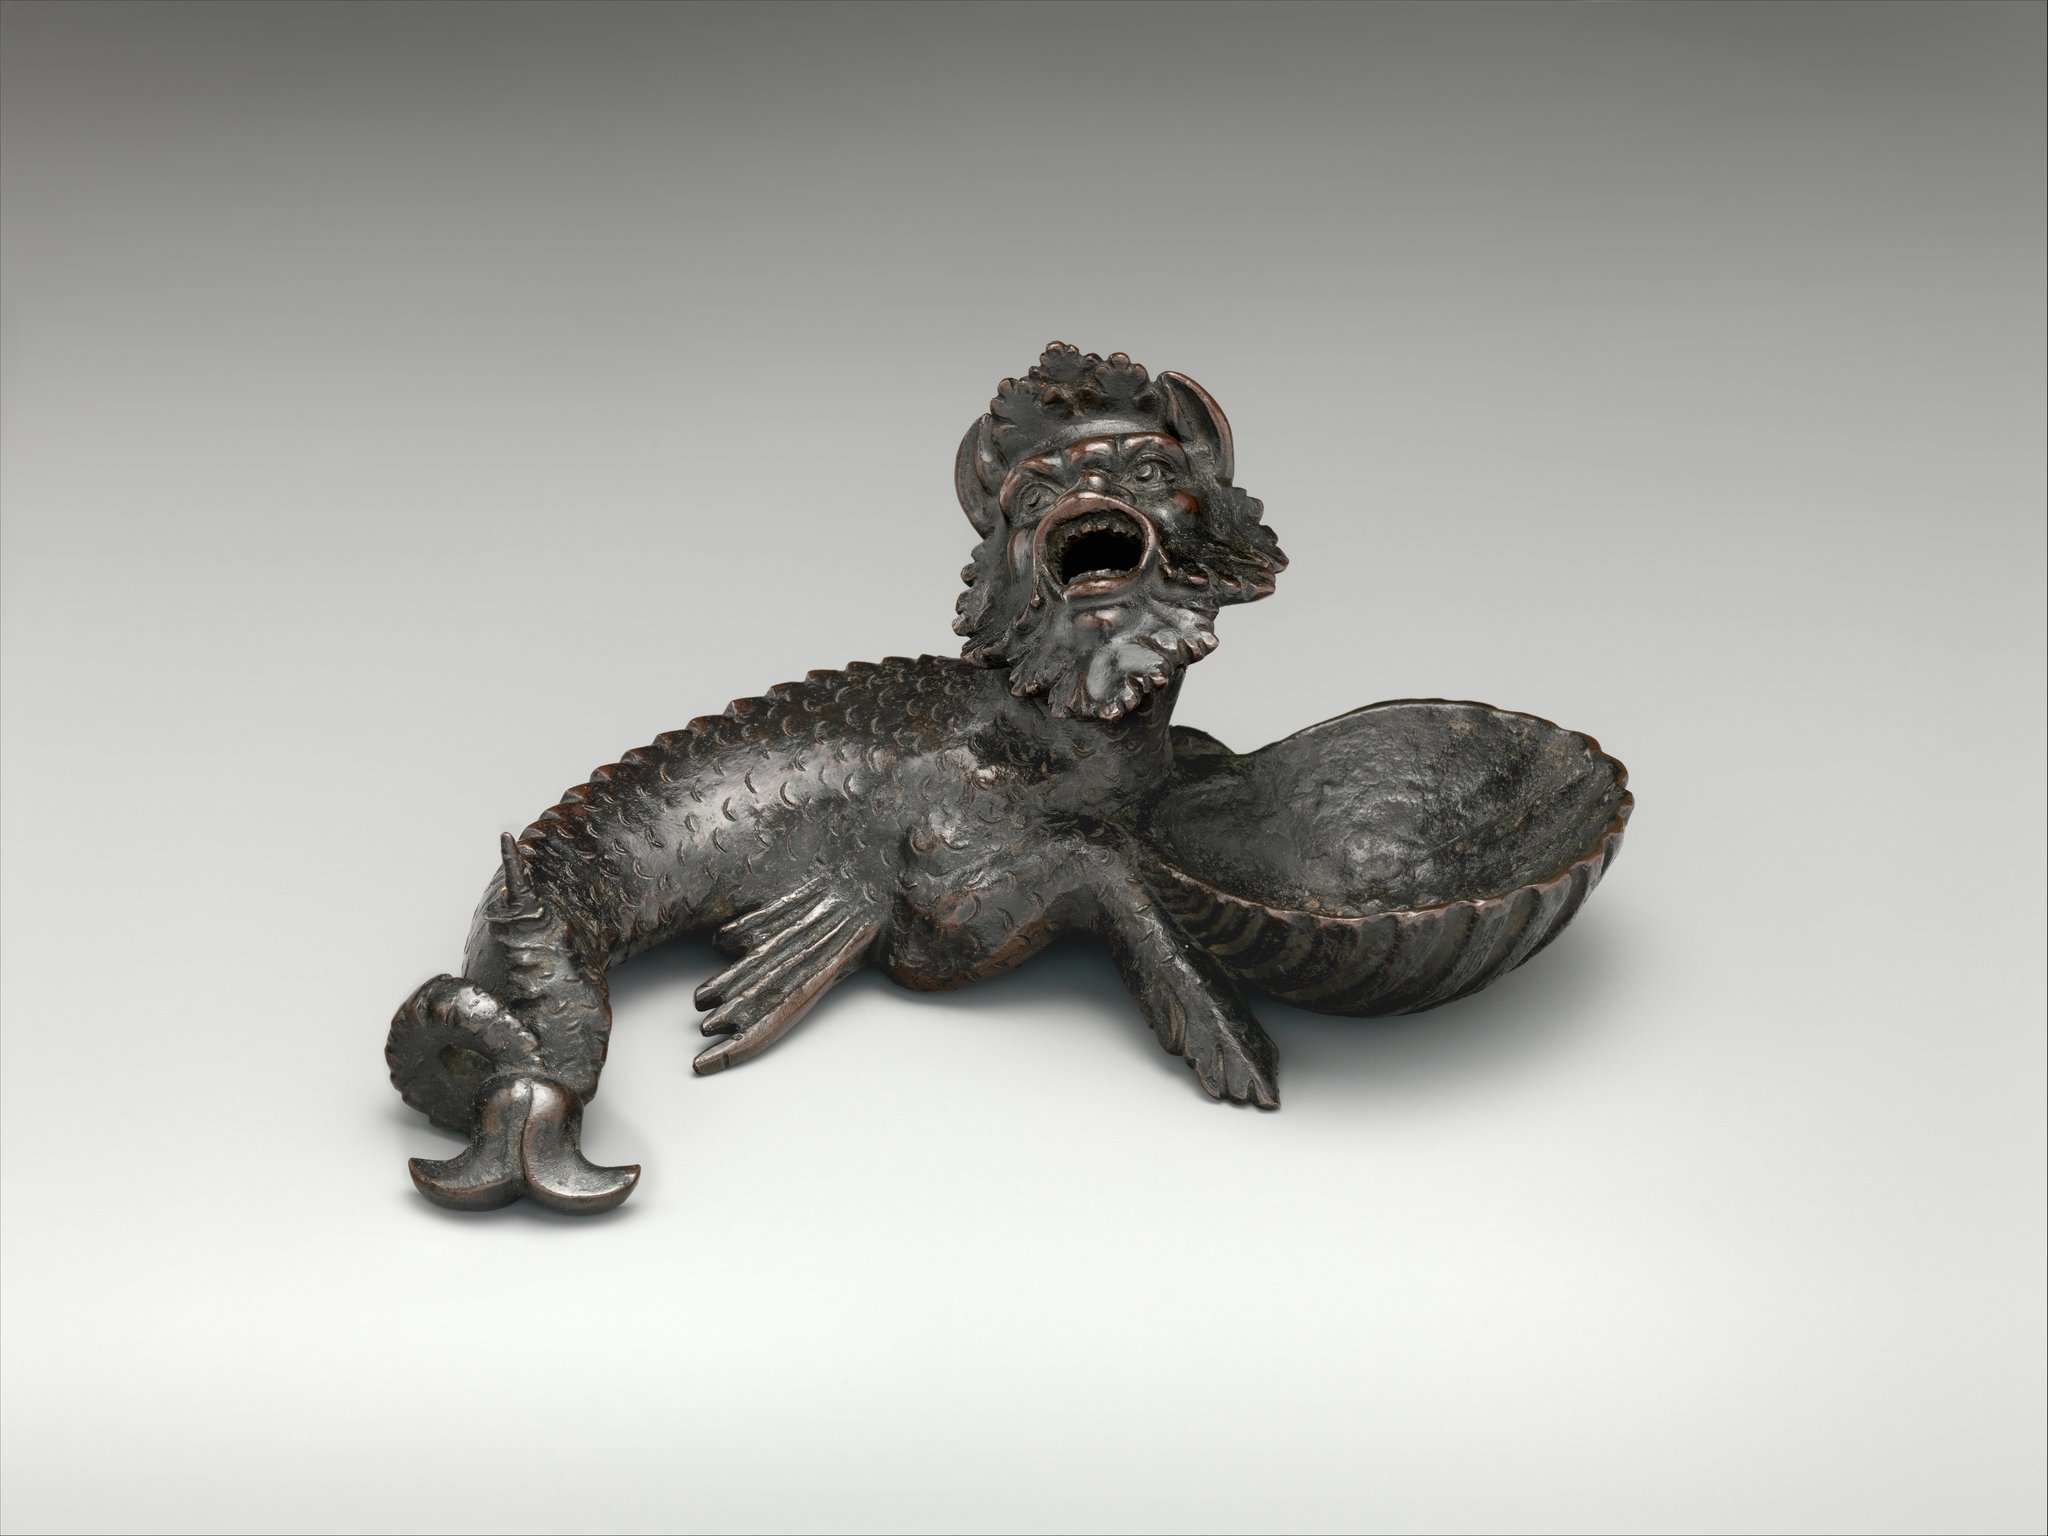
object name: statuette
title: Sea monster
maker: severo calzetta da ravenna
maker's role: artist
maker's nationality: italian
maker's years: 1496-1543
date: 1501-1533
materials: bronze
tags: monsters